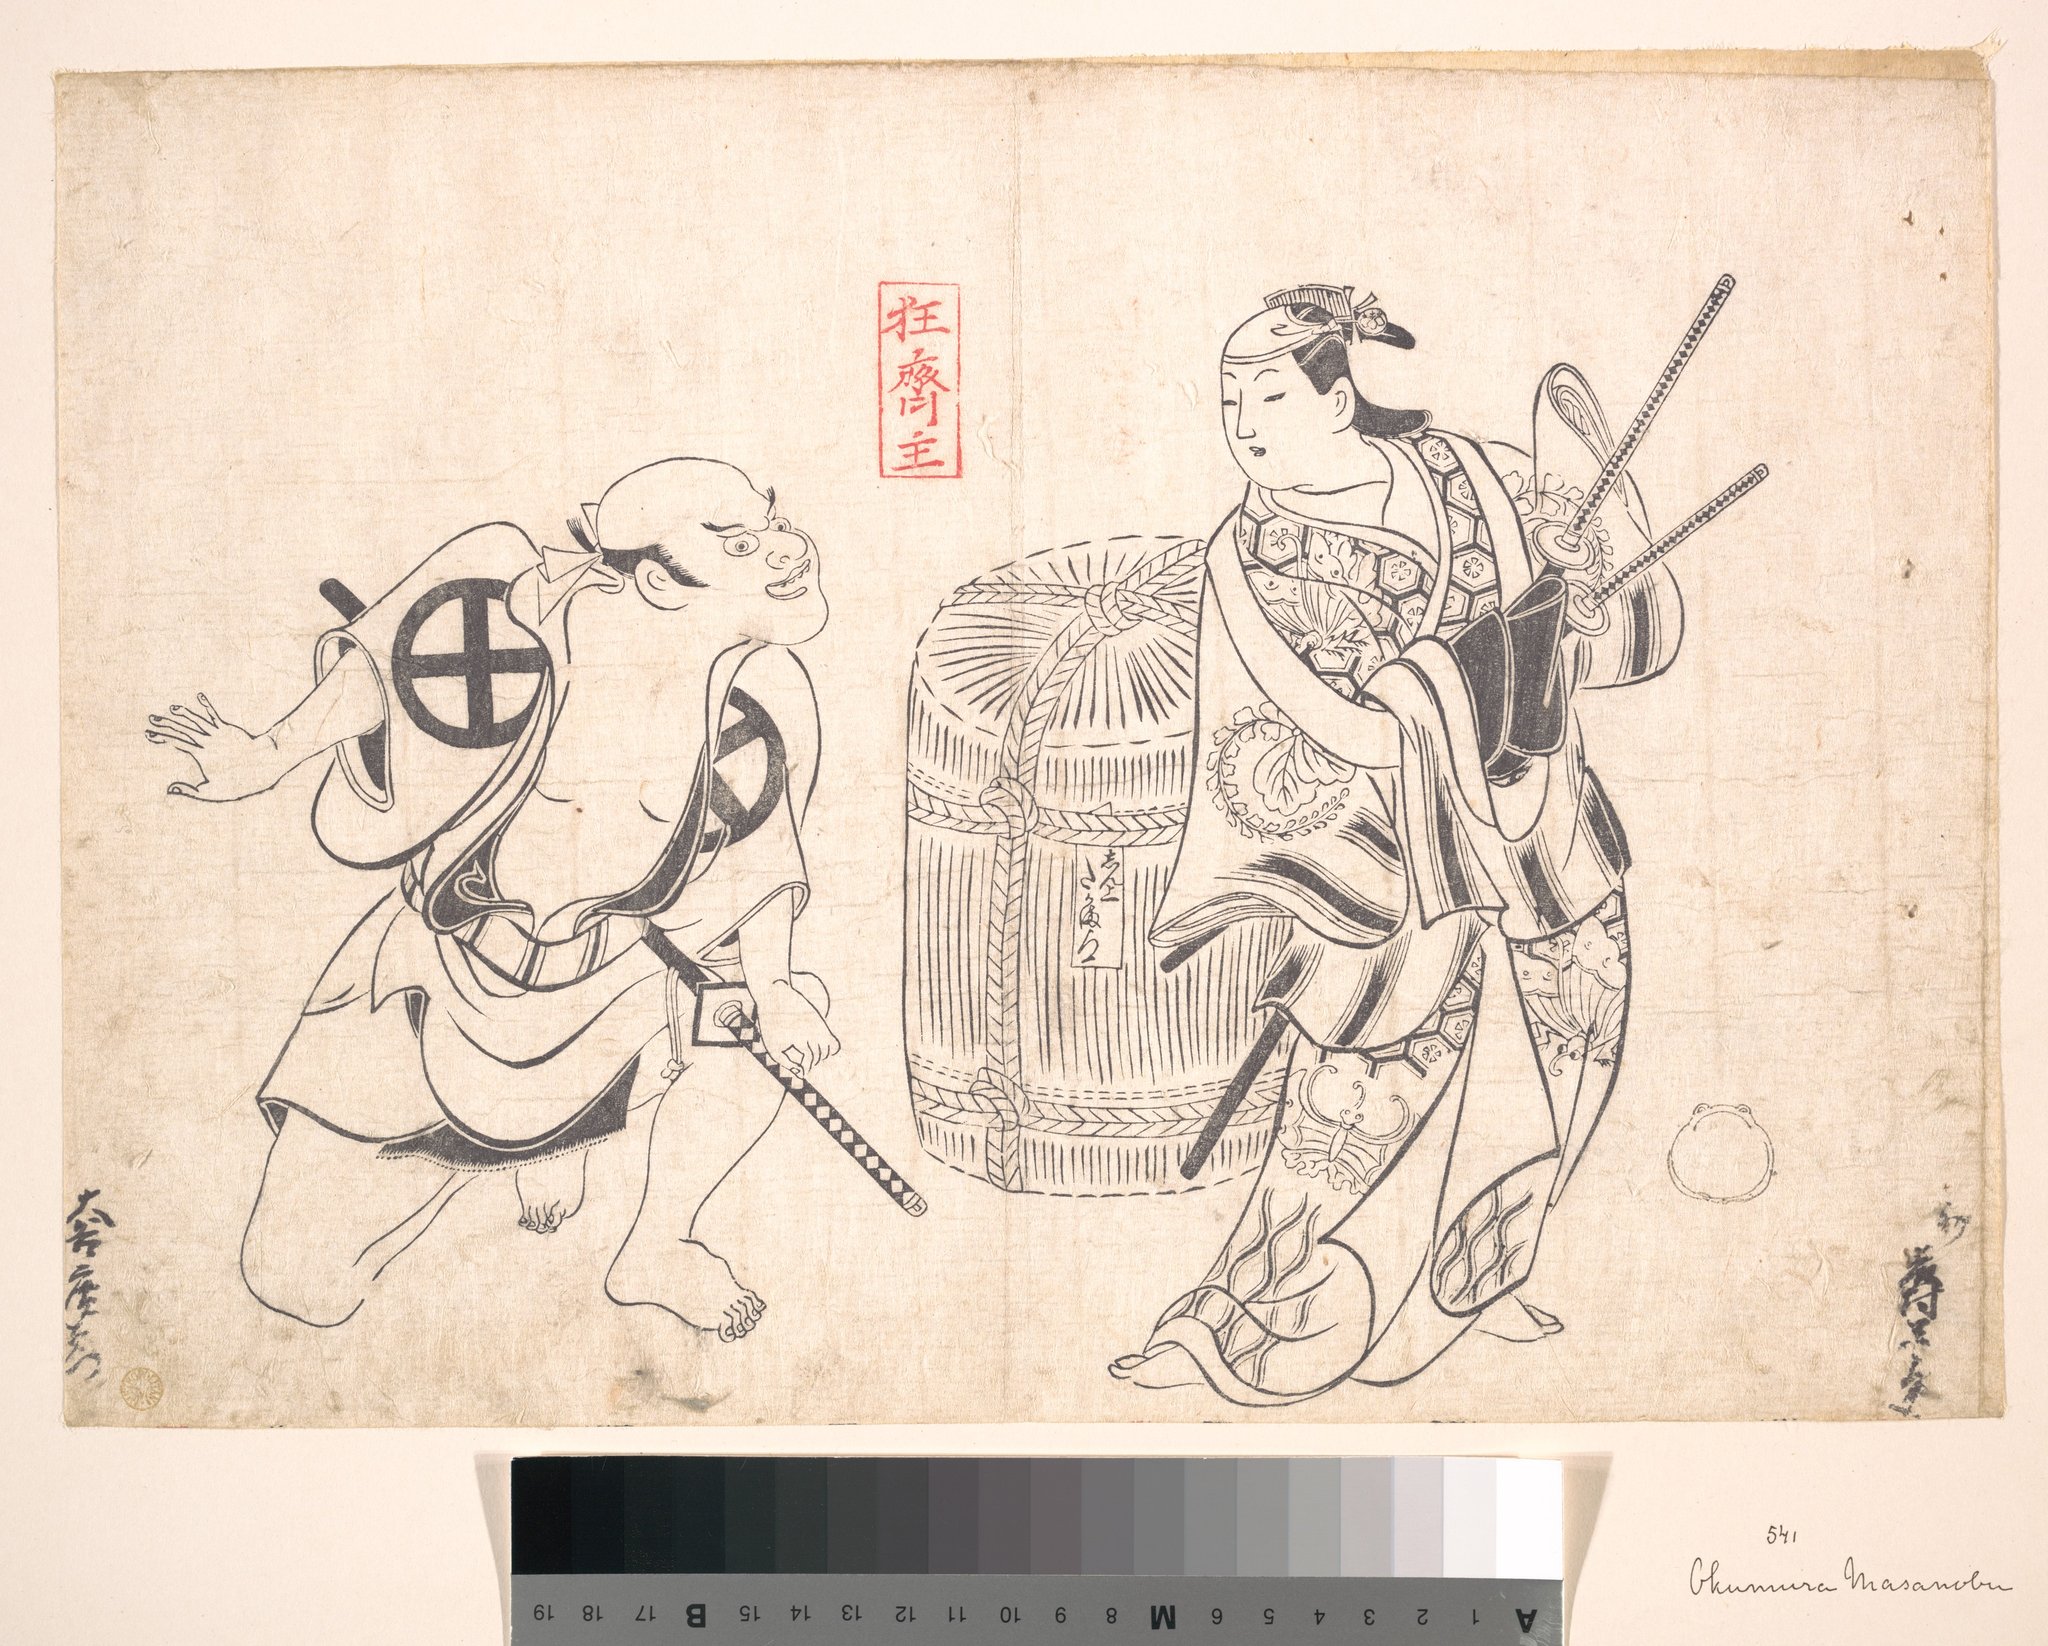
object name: woodblock print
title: Scene from a Drama "Hoshiai Nagoya" Performed at the Nakamura Theatre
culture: japanese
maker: okumura masanobu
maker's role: artist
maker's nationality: japanese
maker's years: 1686-1764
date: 1709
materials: ink, paper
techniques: woodblock print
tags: men,actors